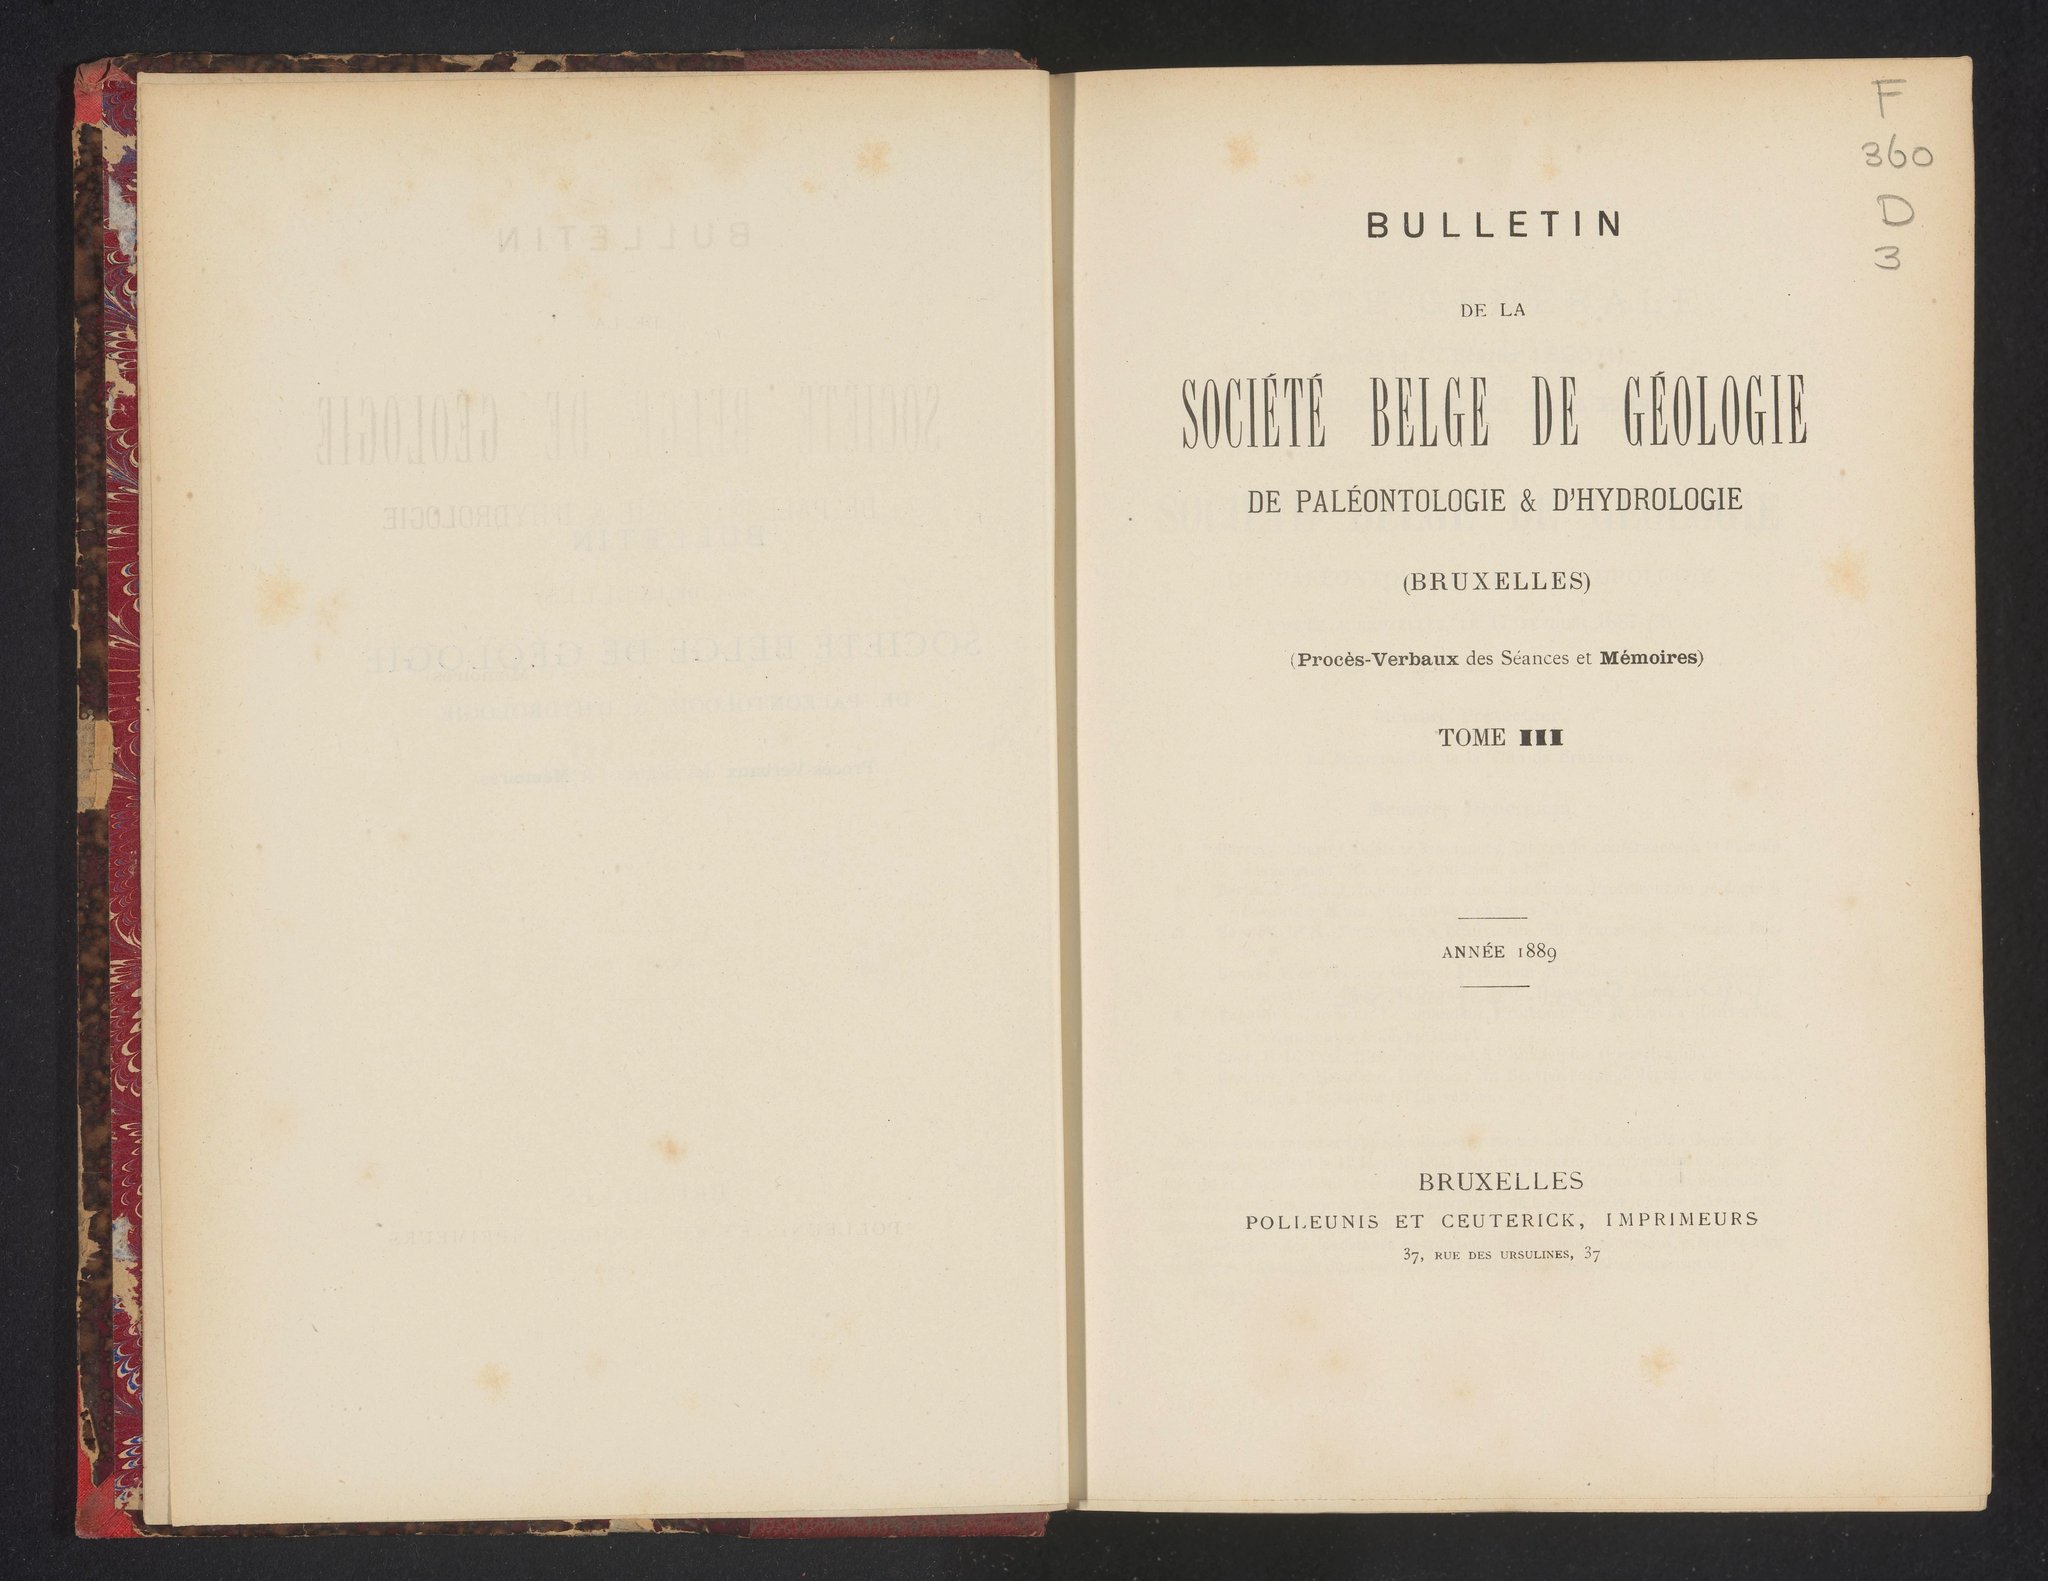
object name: magazine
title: Bulletin de la Société belge de géologie, de paléontologie et d'hydrologie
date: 1889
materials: linen, paper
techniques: photograph, combed marbled paper, lithograph, printing, engraving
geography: brussels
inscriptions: number: ‘2000’